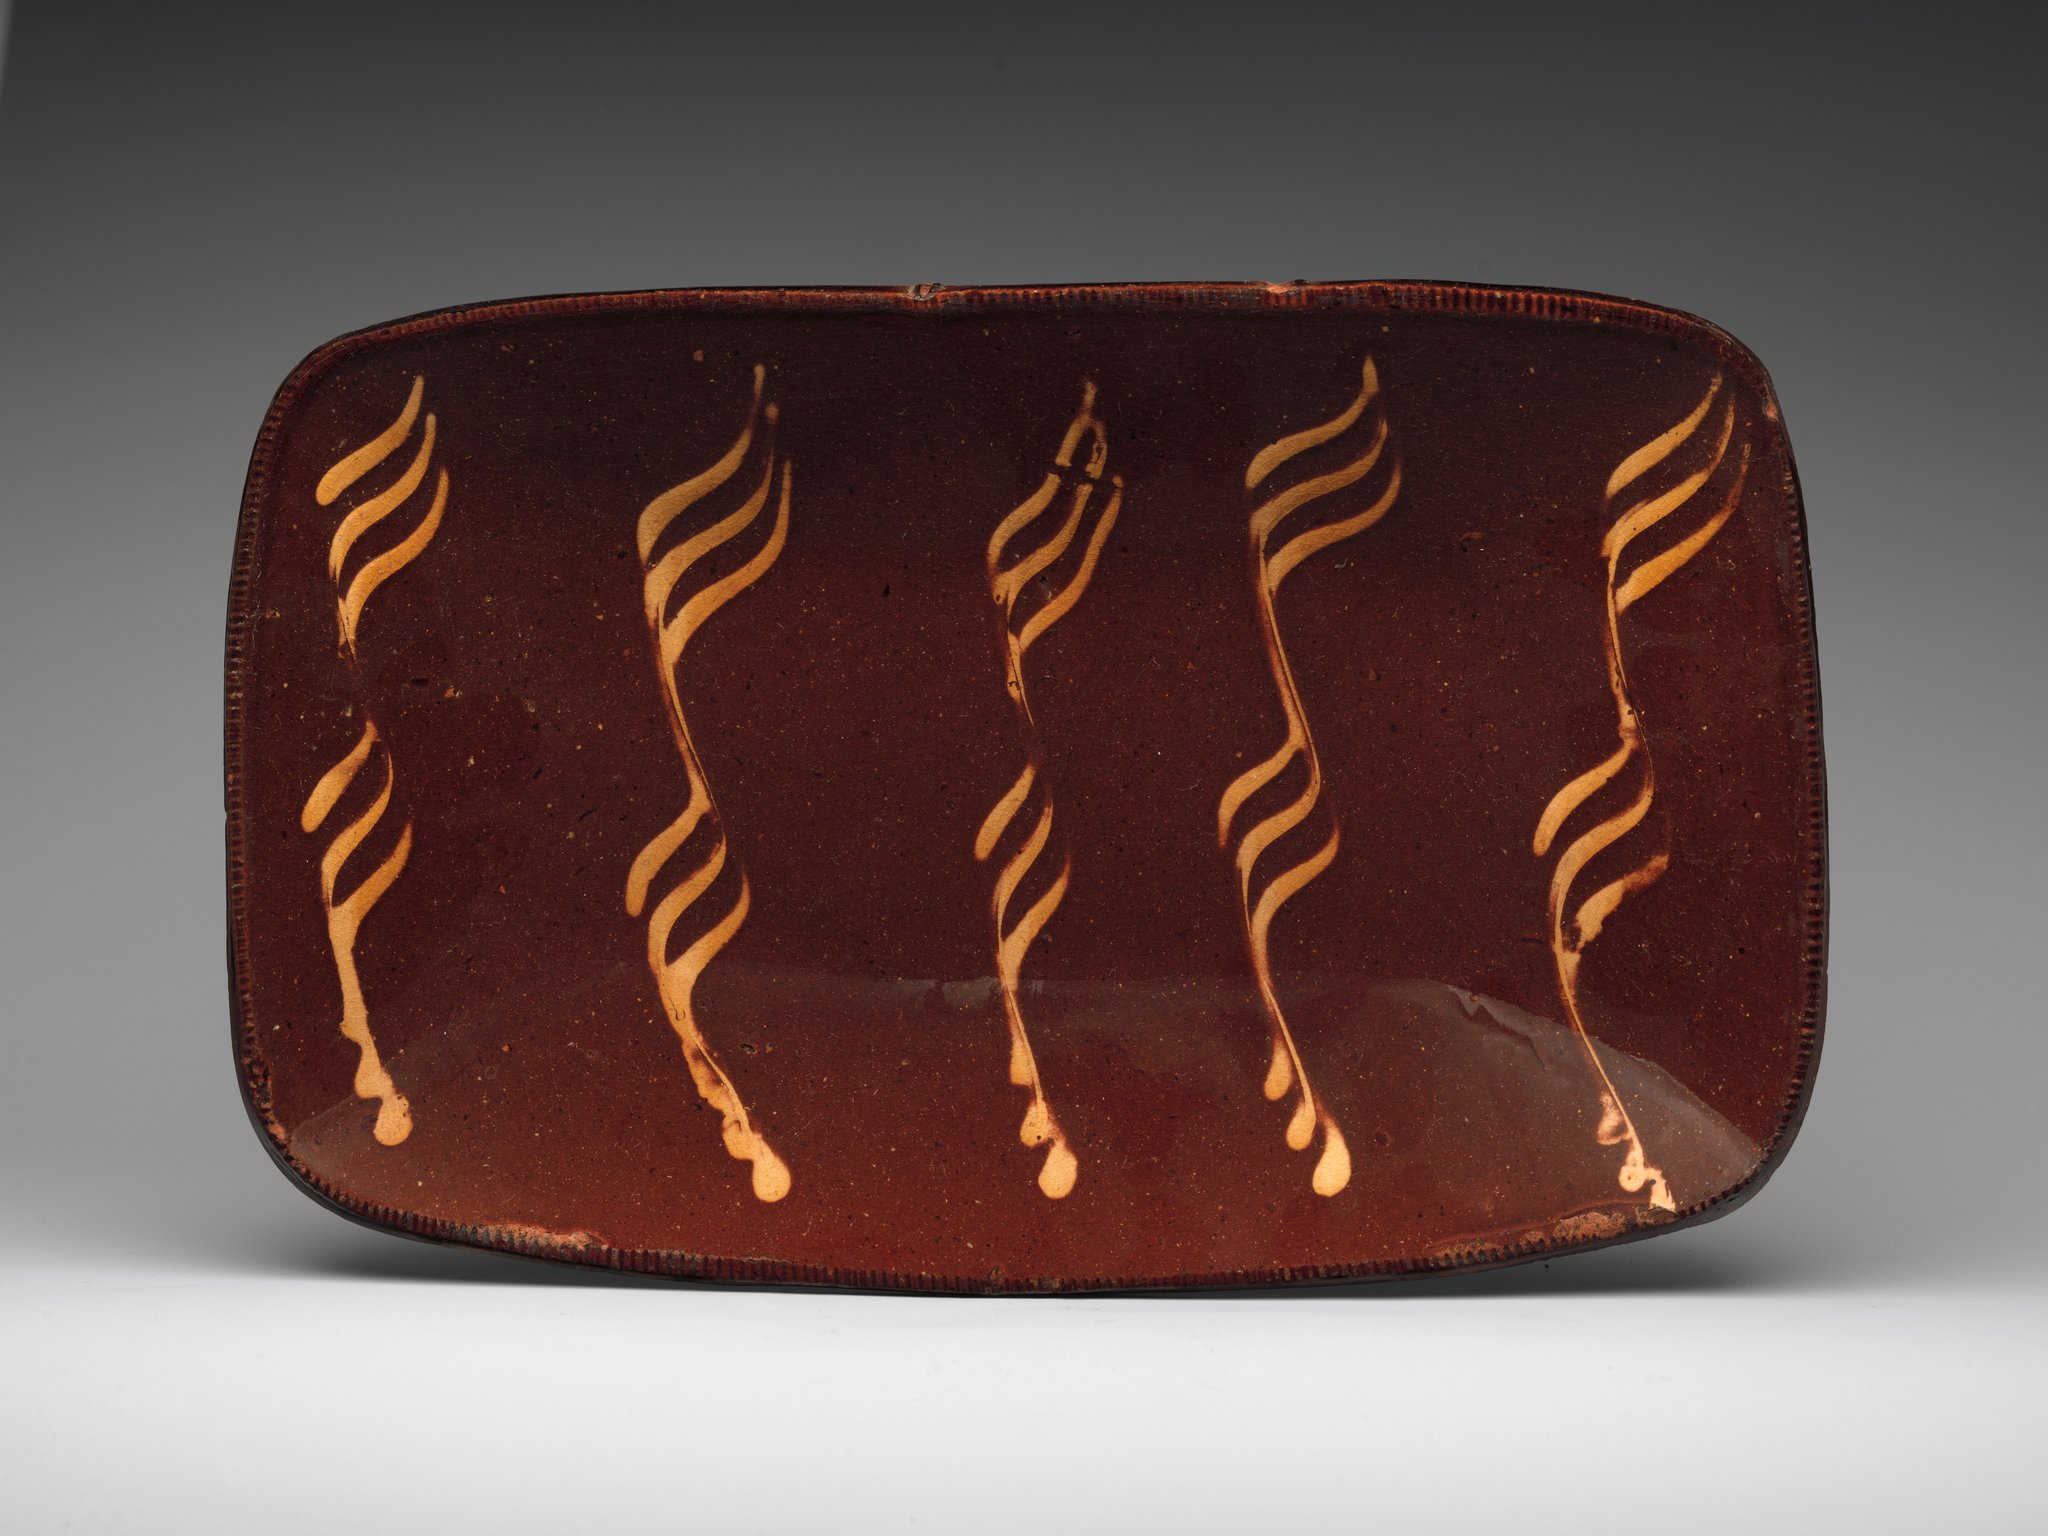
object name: platter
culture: british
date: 1800-1830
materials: earthenware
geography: england